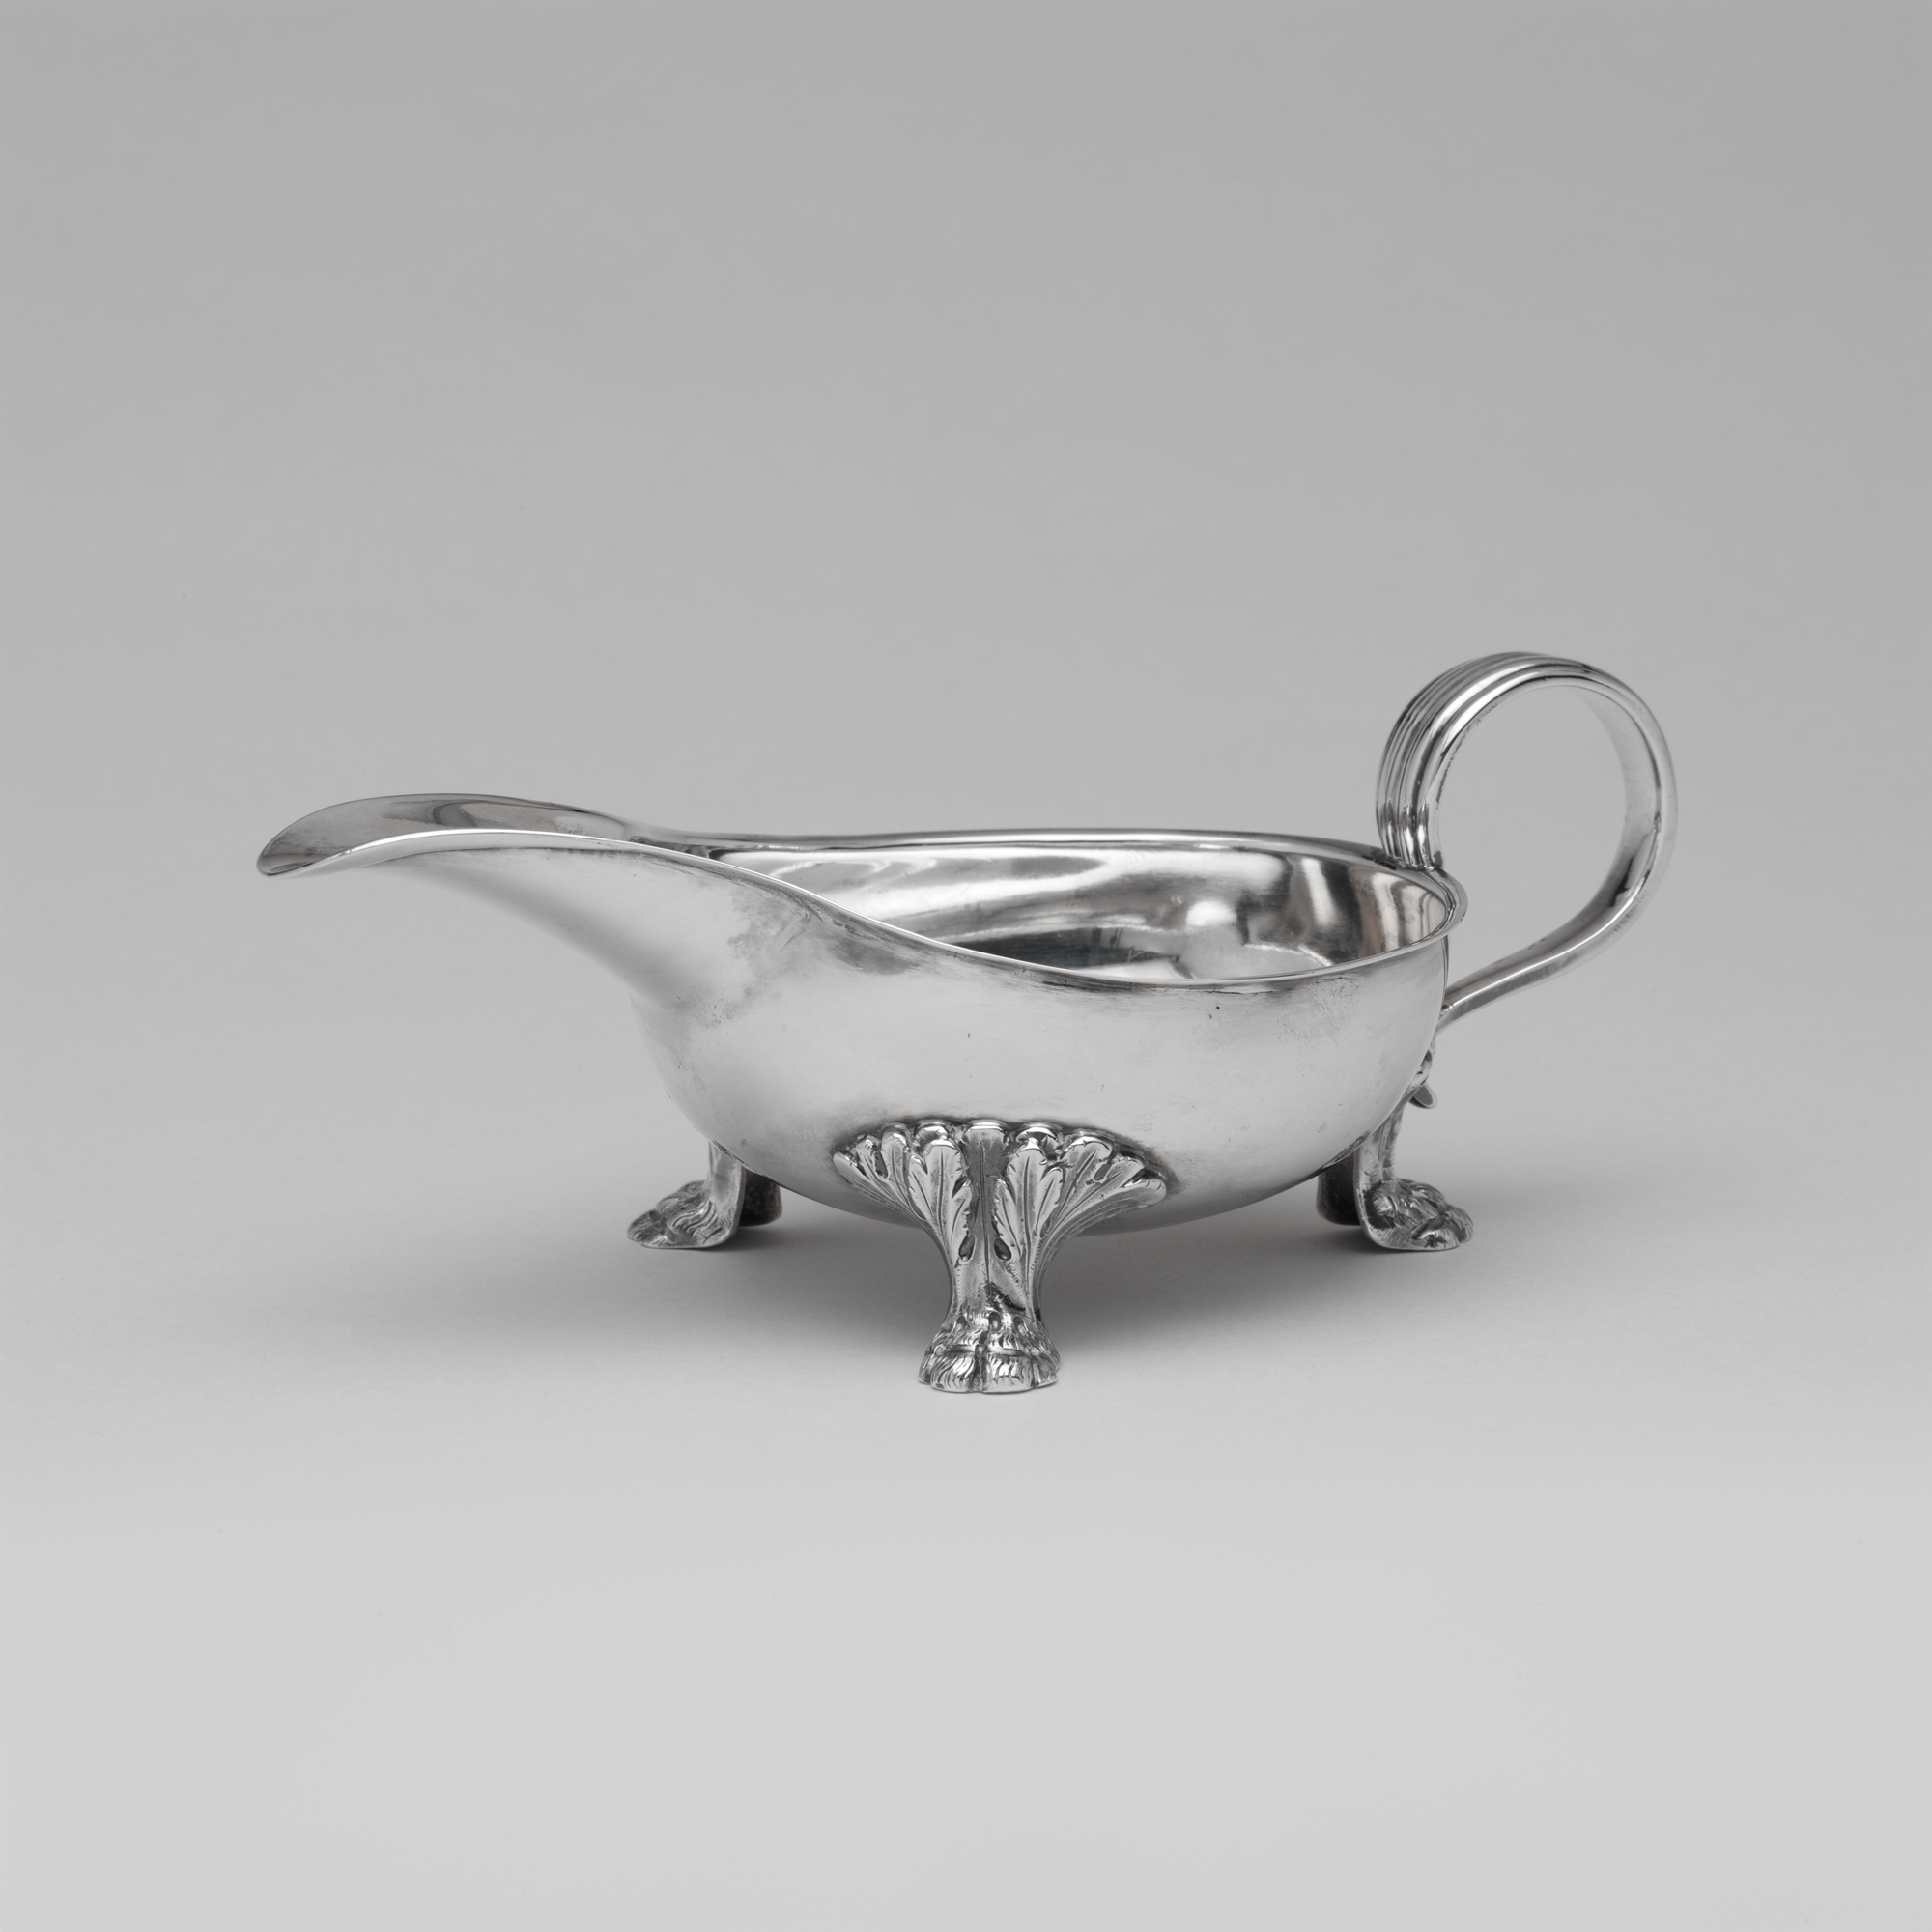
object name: sauceboat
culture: american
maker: eoff and conner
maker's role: maker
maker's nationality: american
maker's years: 1833-1834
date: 1833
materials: silver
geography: united states